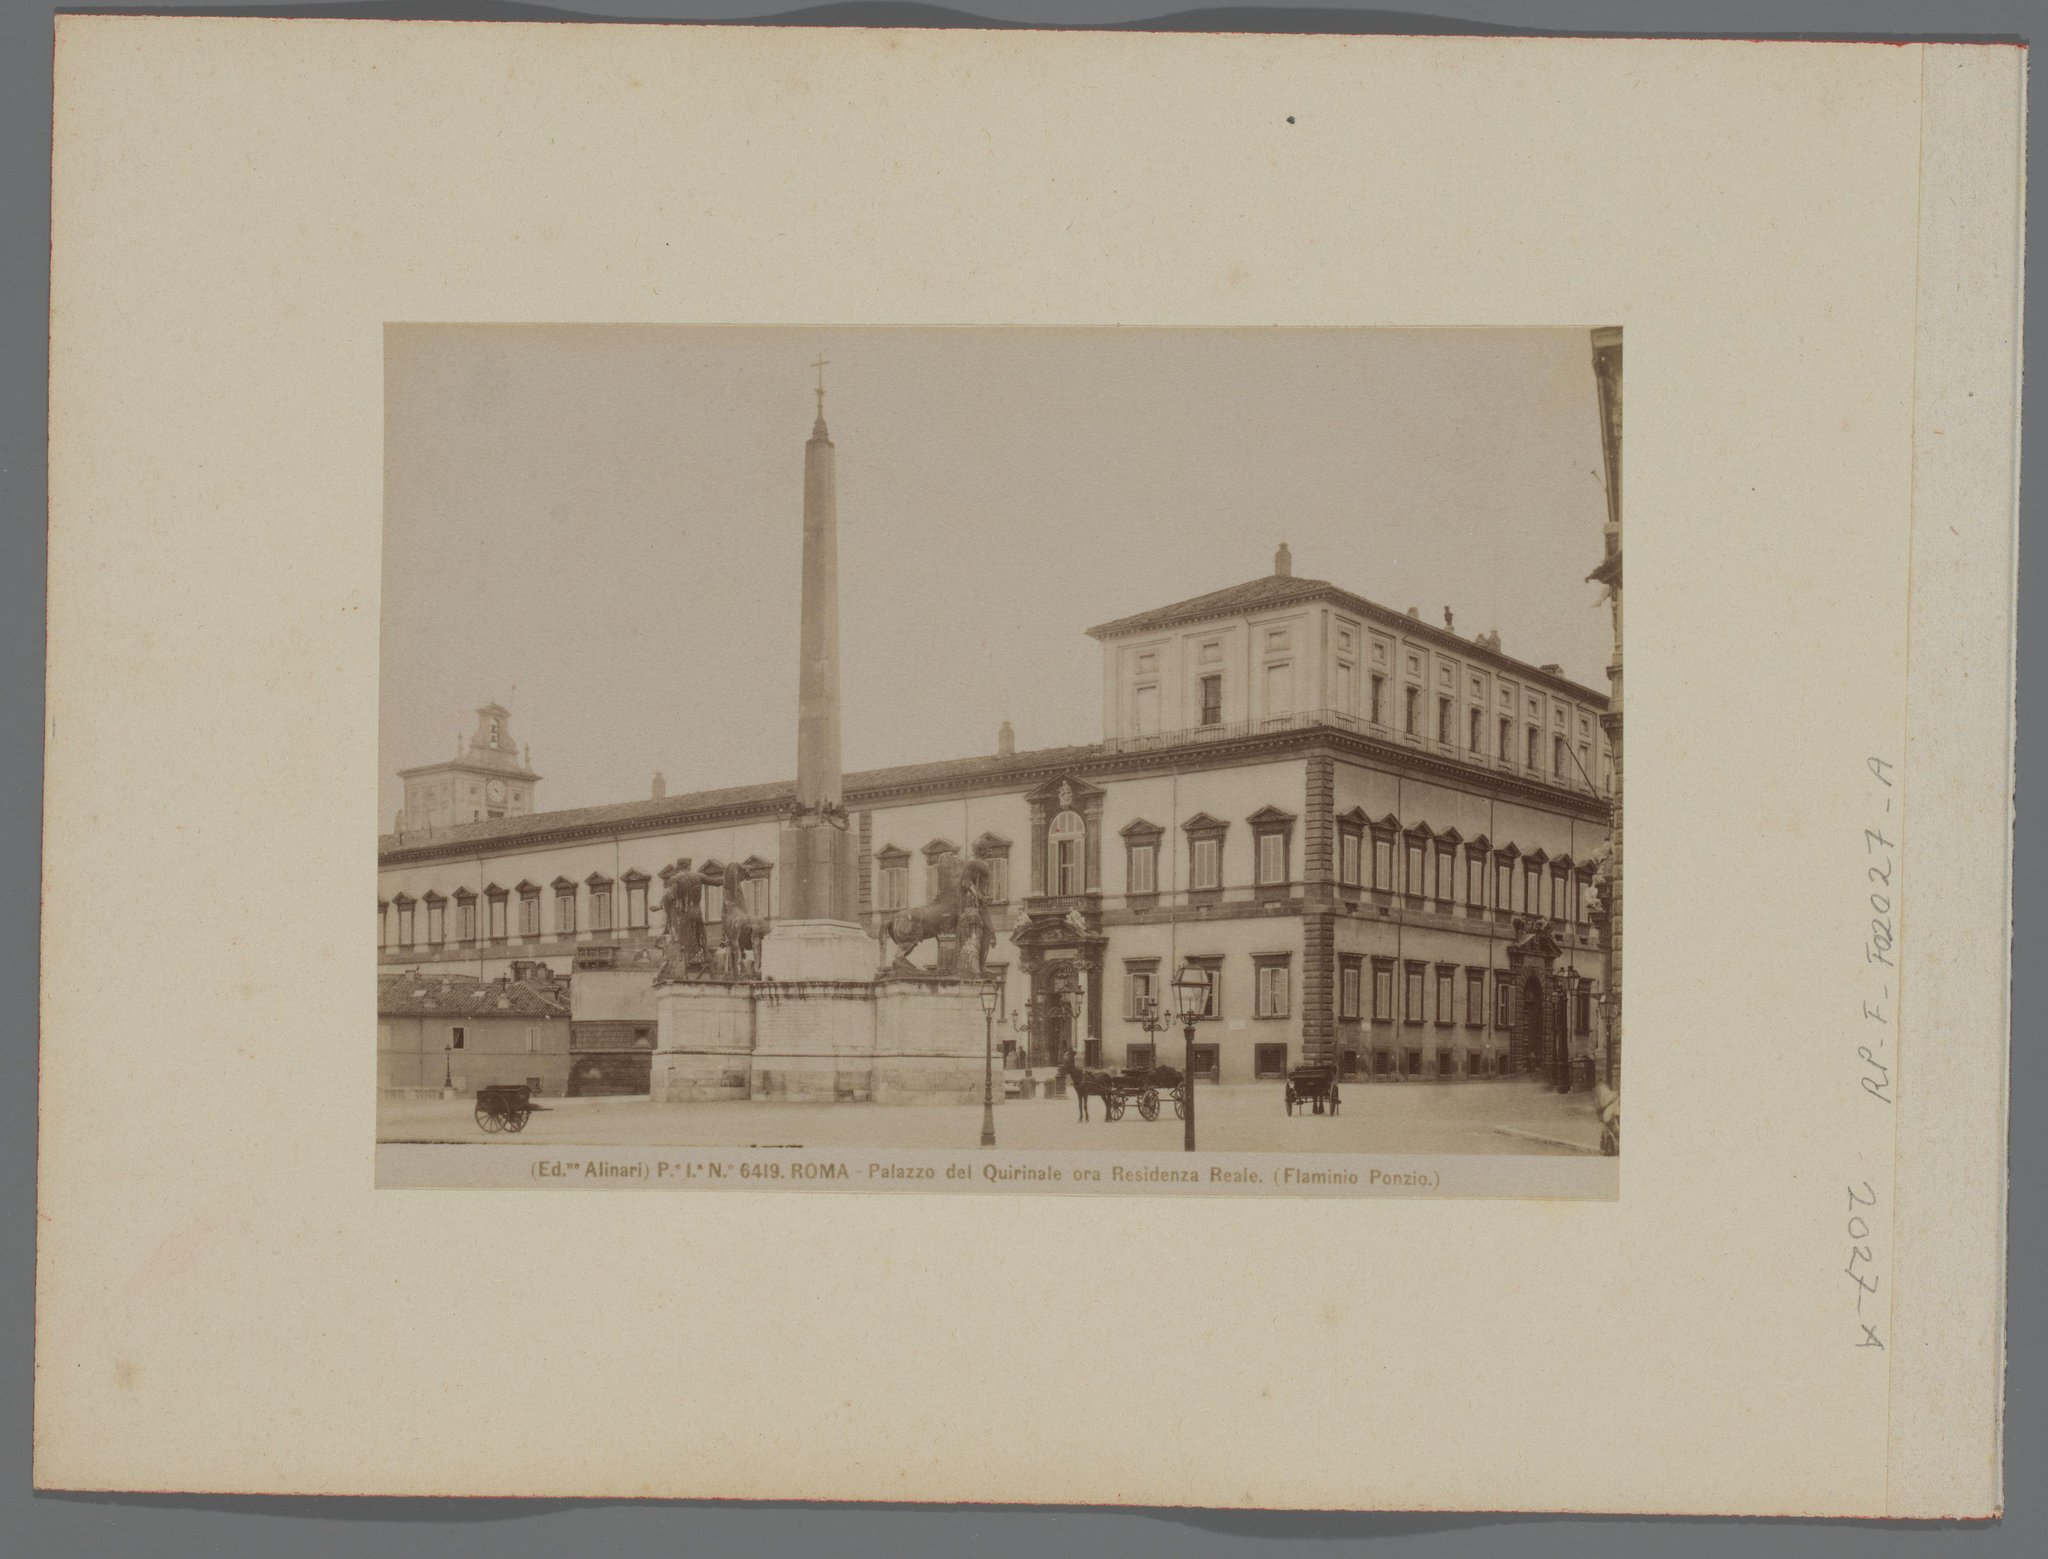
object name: photograph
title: Palazzo del Quirinale ora Residenza Reale (F. Ponzio)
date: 1852-1900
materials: cardboard, paper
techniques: albumen print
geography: rome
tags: square, place, circus, etc., obelisk, needle, hôtel, i.e. small palace in city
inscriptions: number: ‘Pe. Ia. No. 6419.’